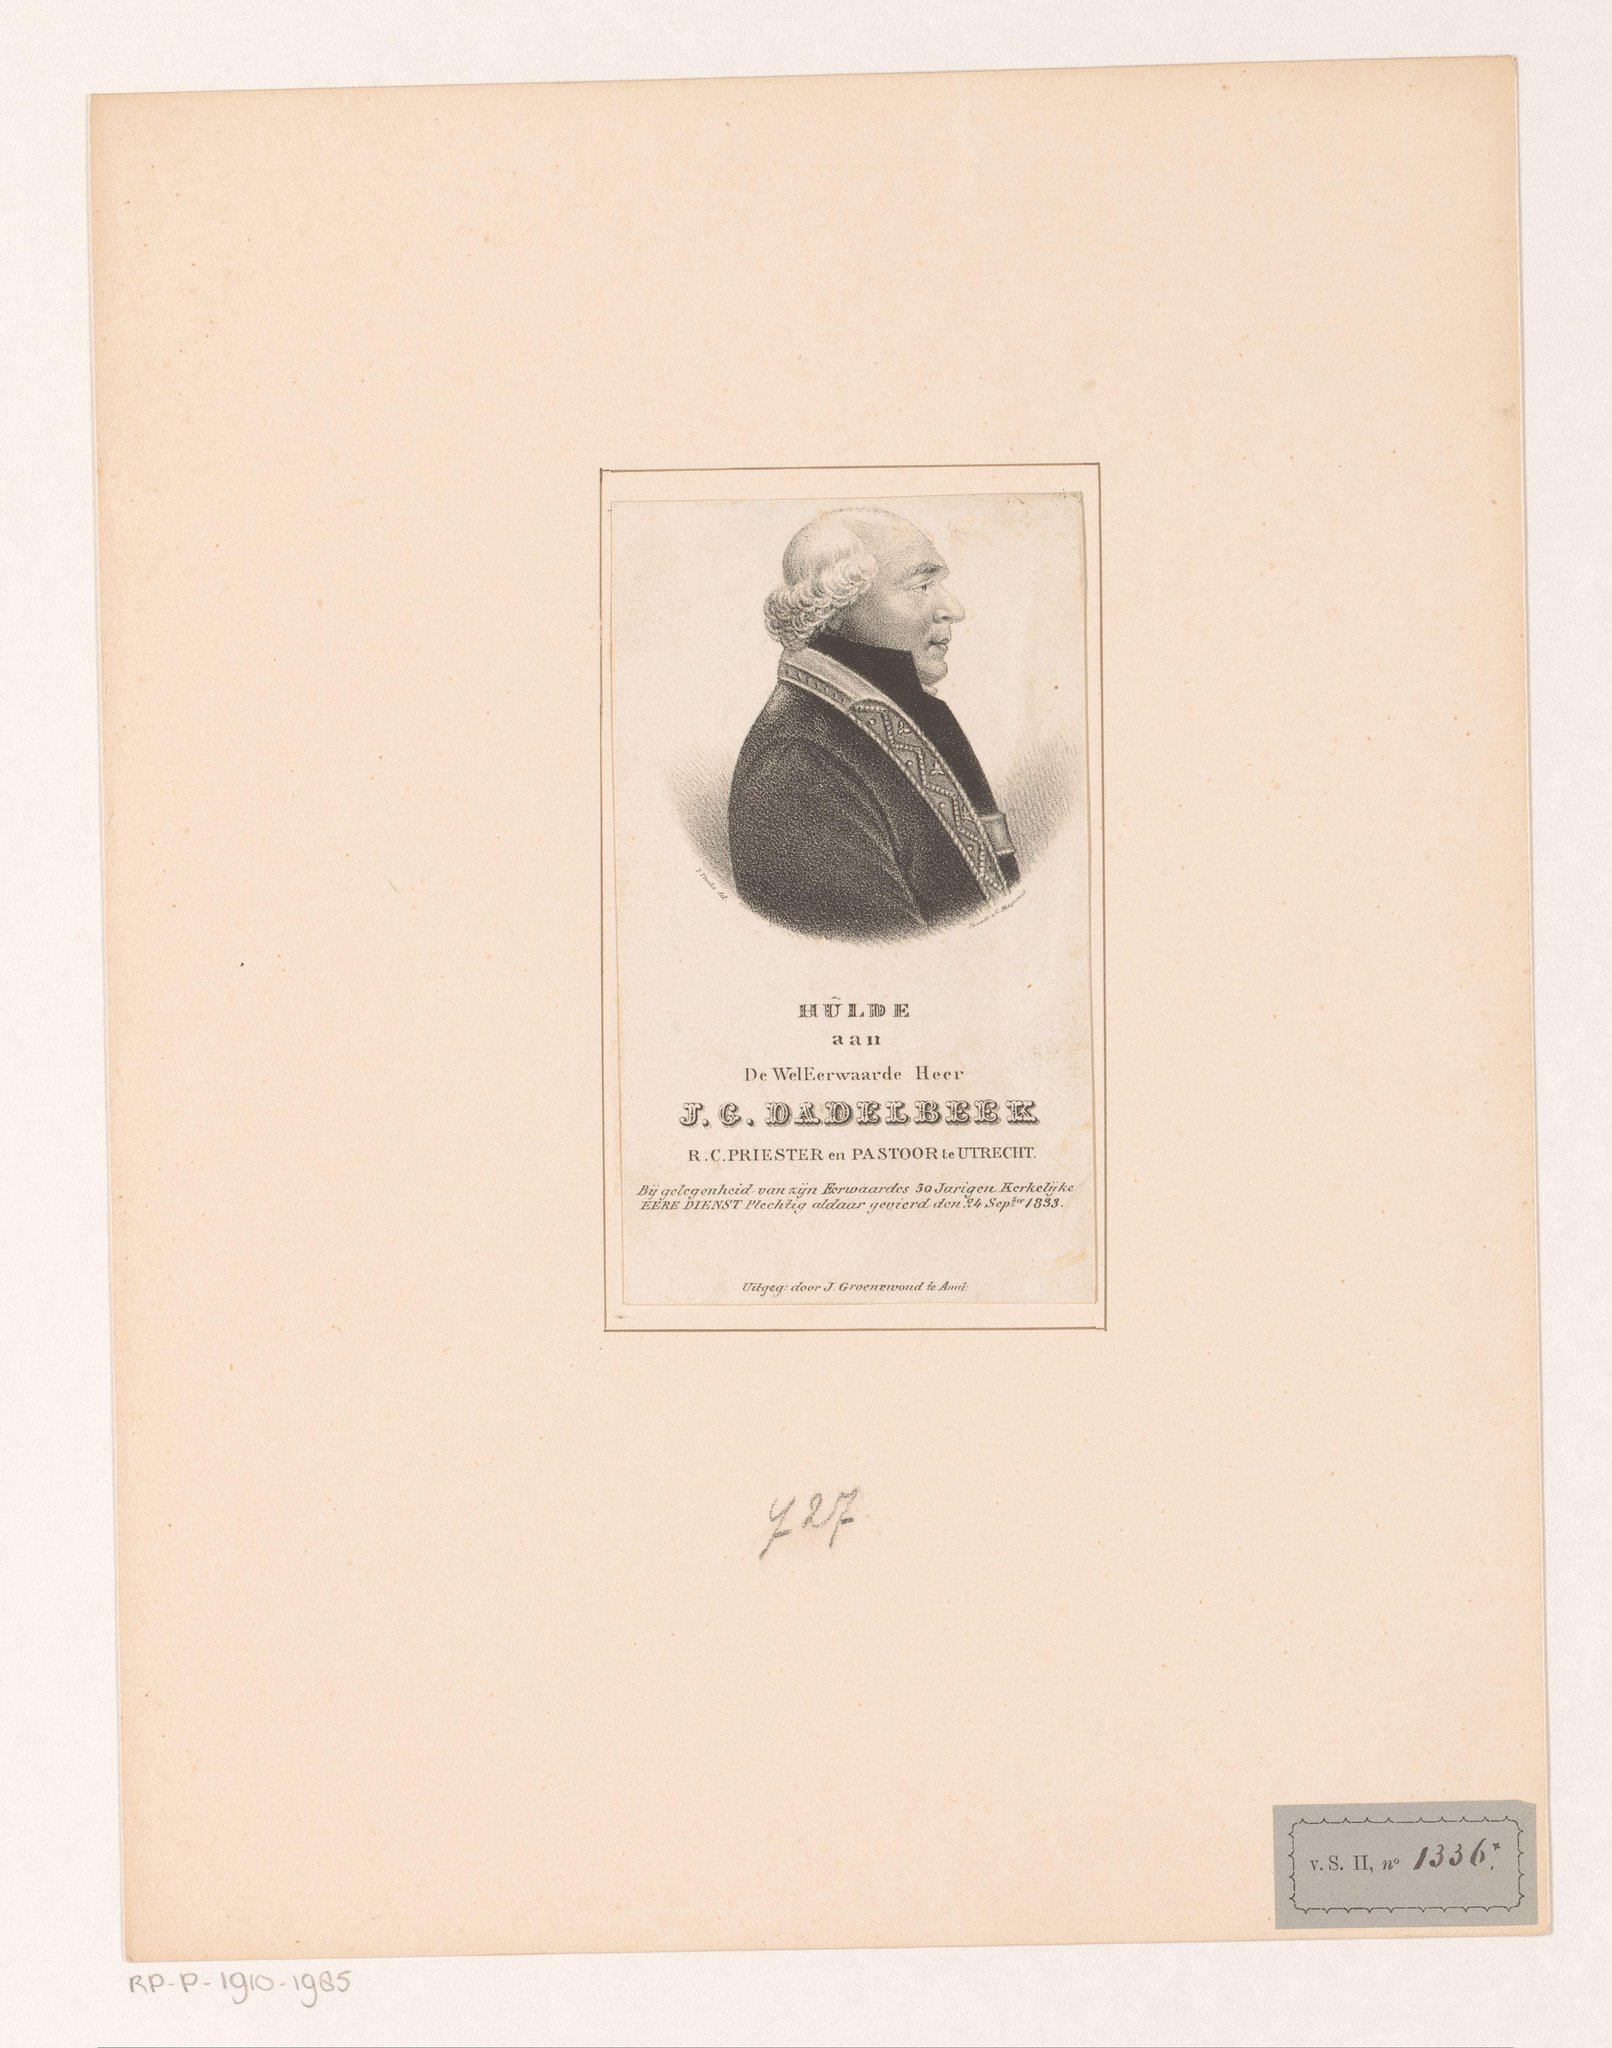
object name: print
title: Portret van Johannes Gerardus van Dadelbeek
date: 1833-1837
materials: paper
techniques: lithograph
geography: amsterdam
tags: utrecht, historical persons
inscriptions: collector's mark: Lugt 2228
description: Hulde bij zijn dertigjarig dienstjubileum in 1833.